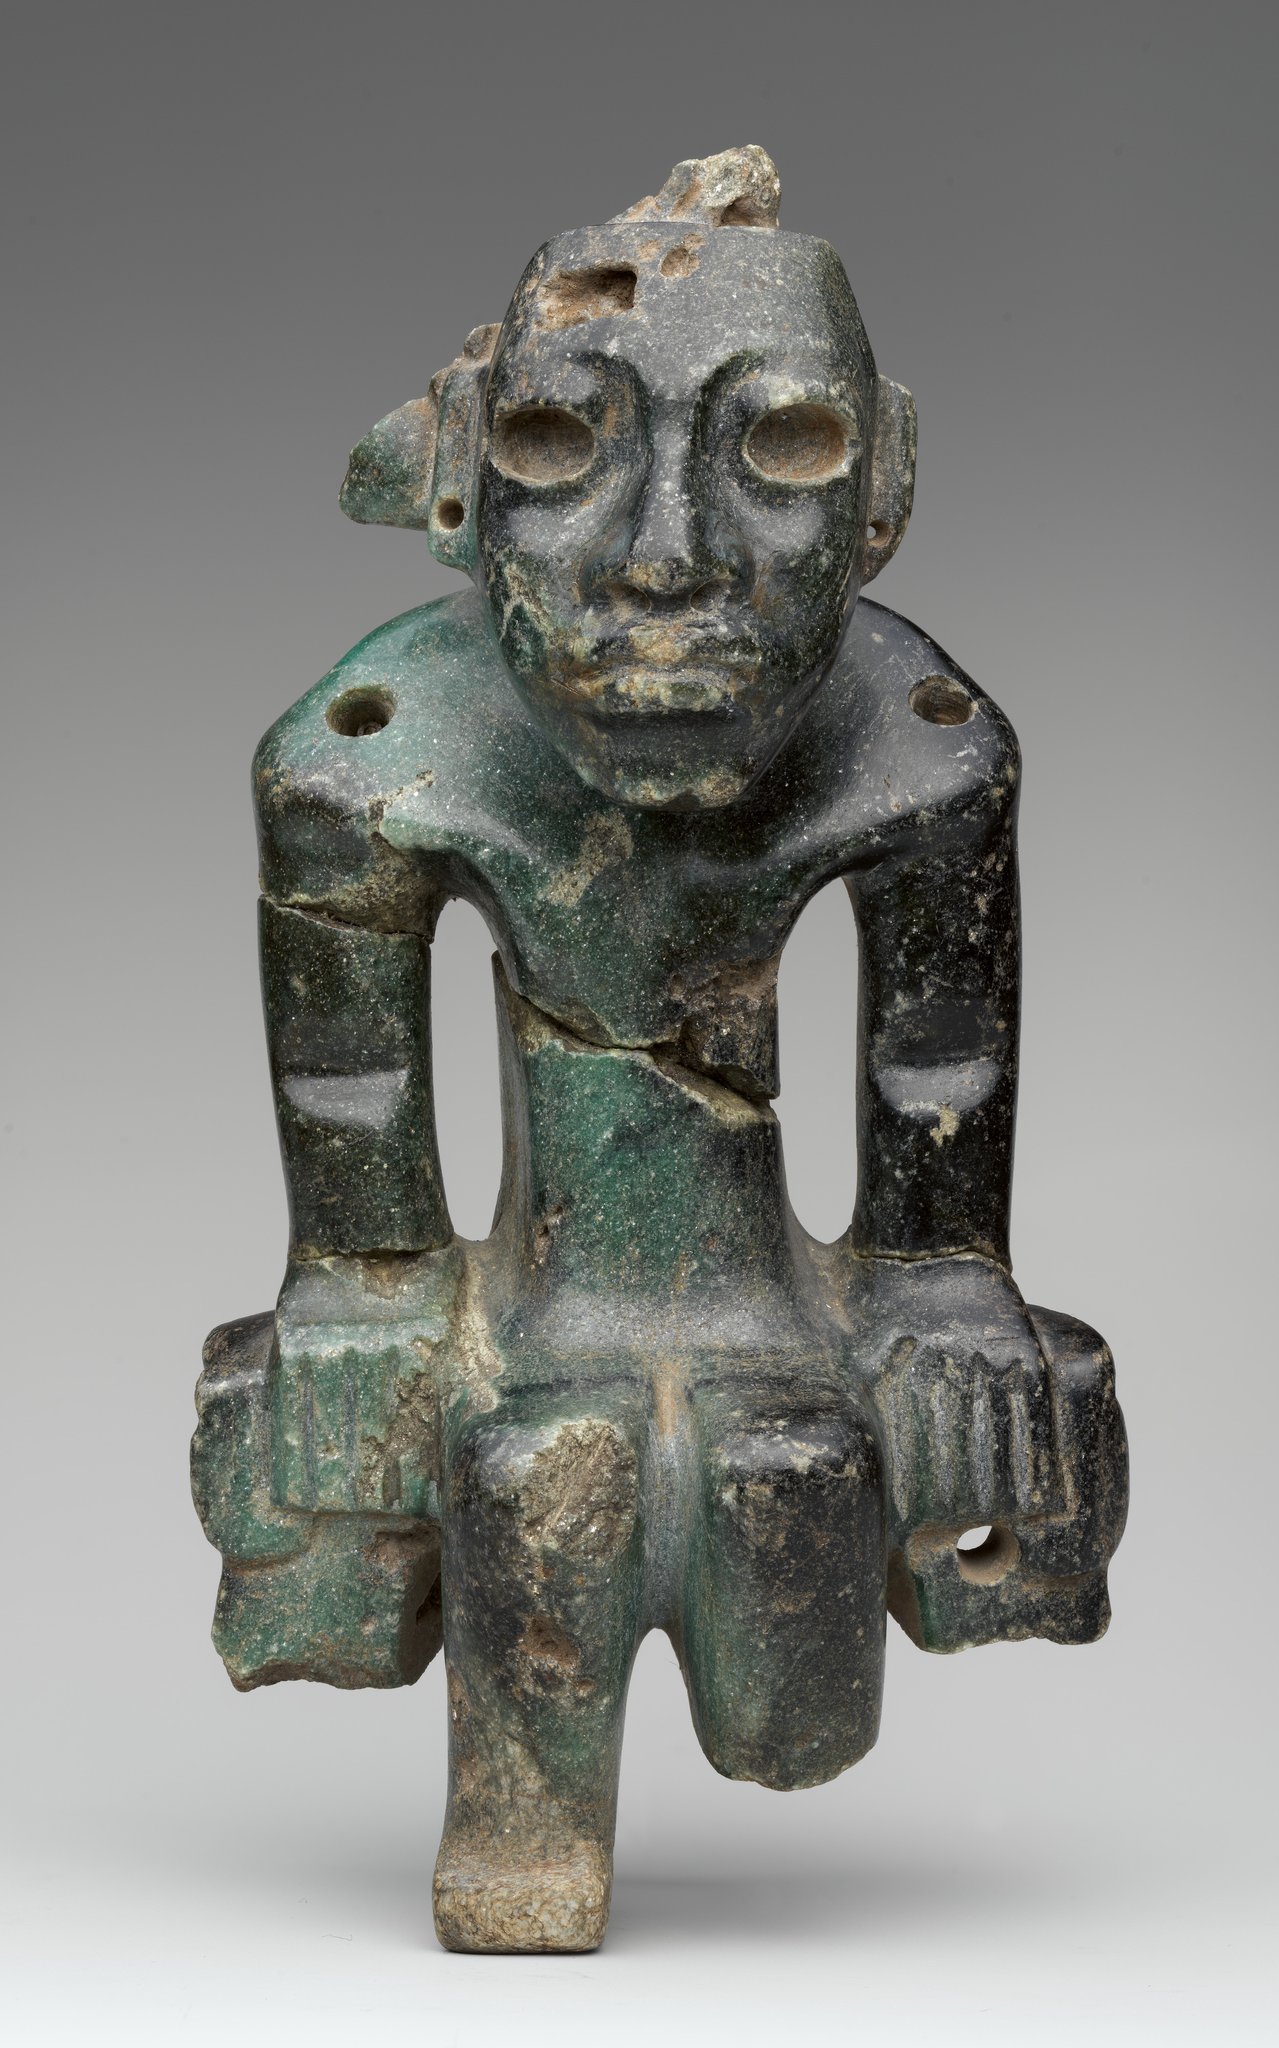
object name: male figure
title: Bench Figure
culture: epi-olmec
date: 500-101 BCE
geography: mexico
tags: men